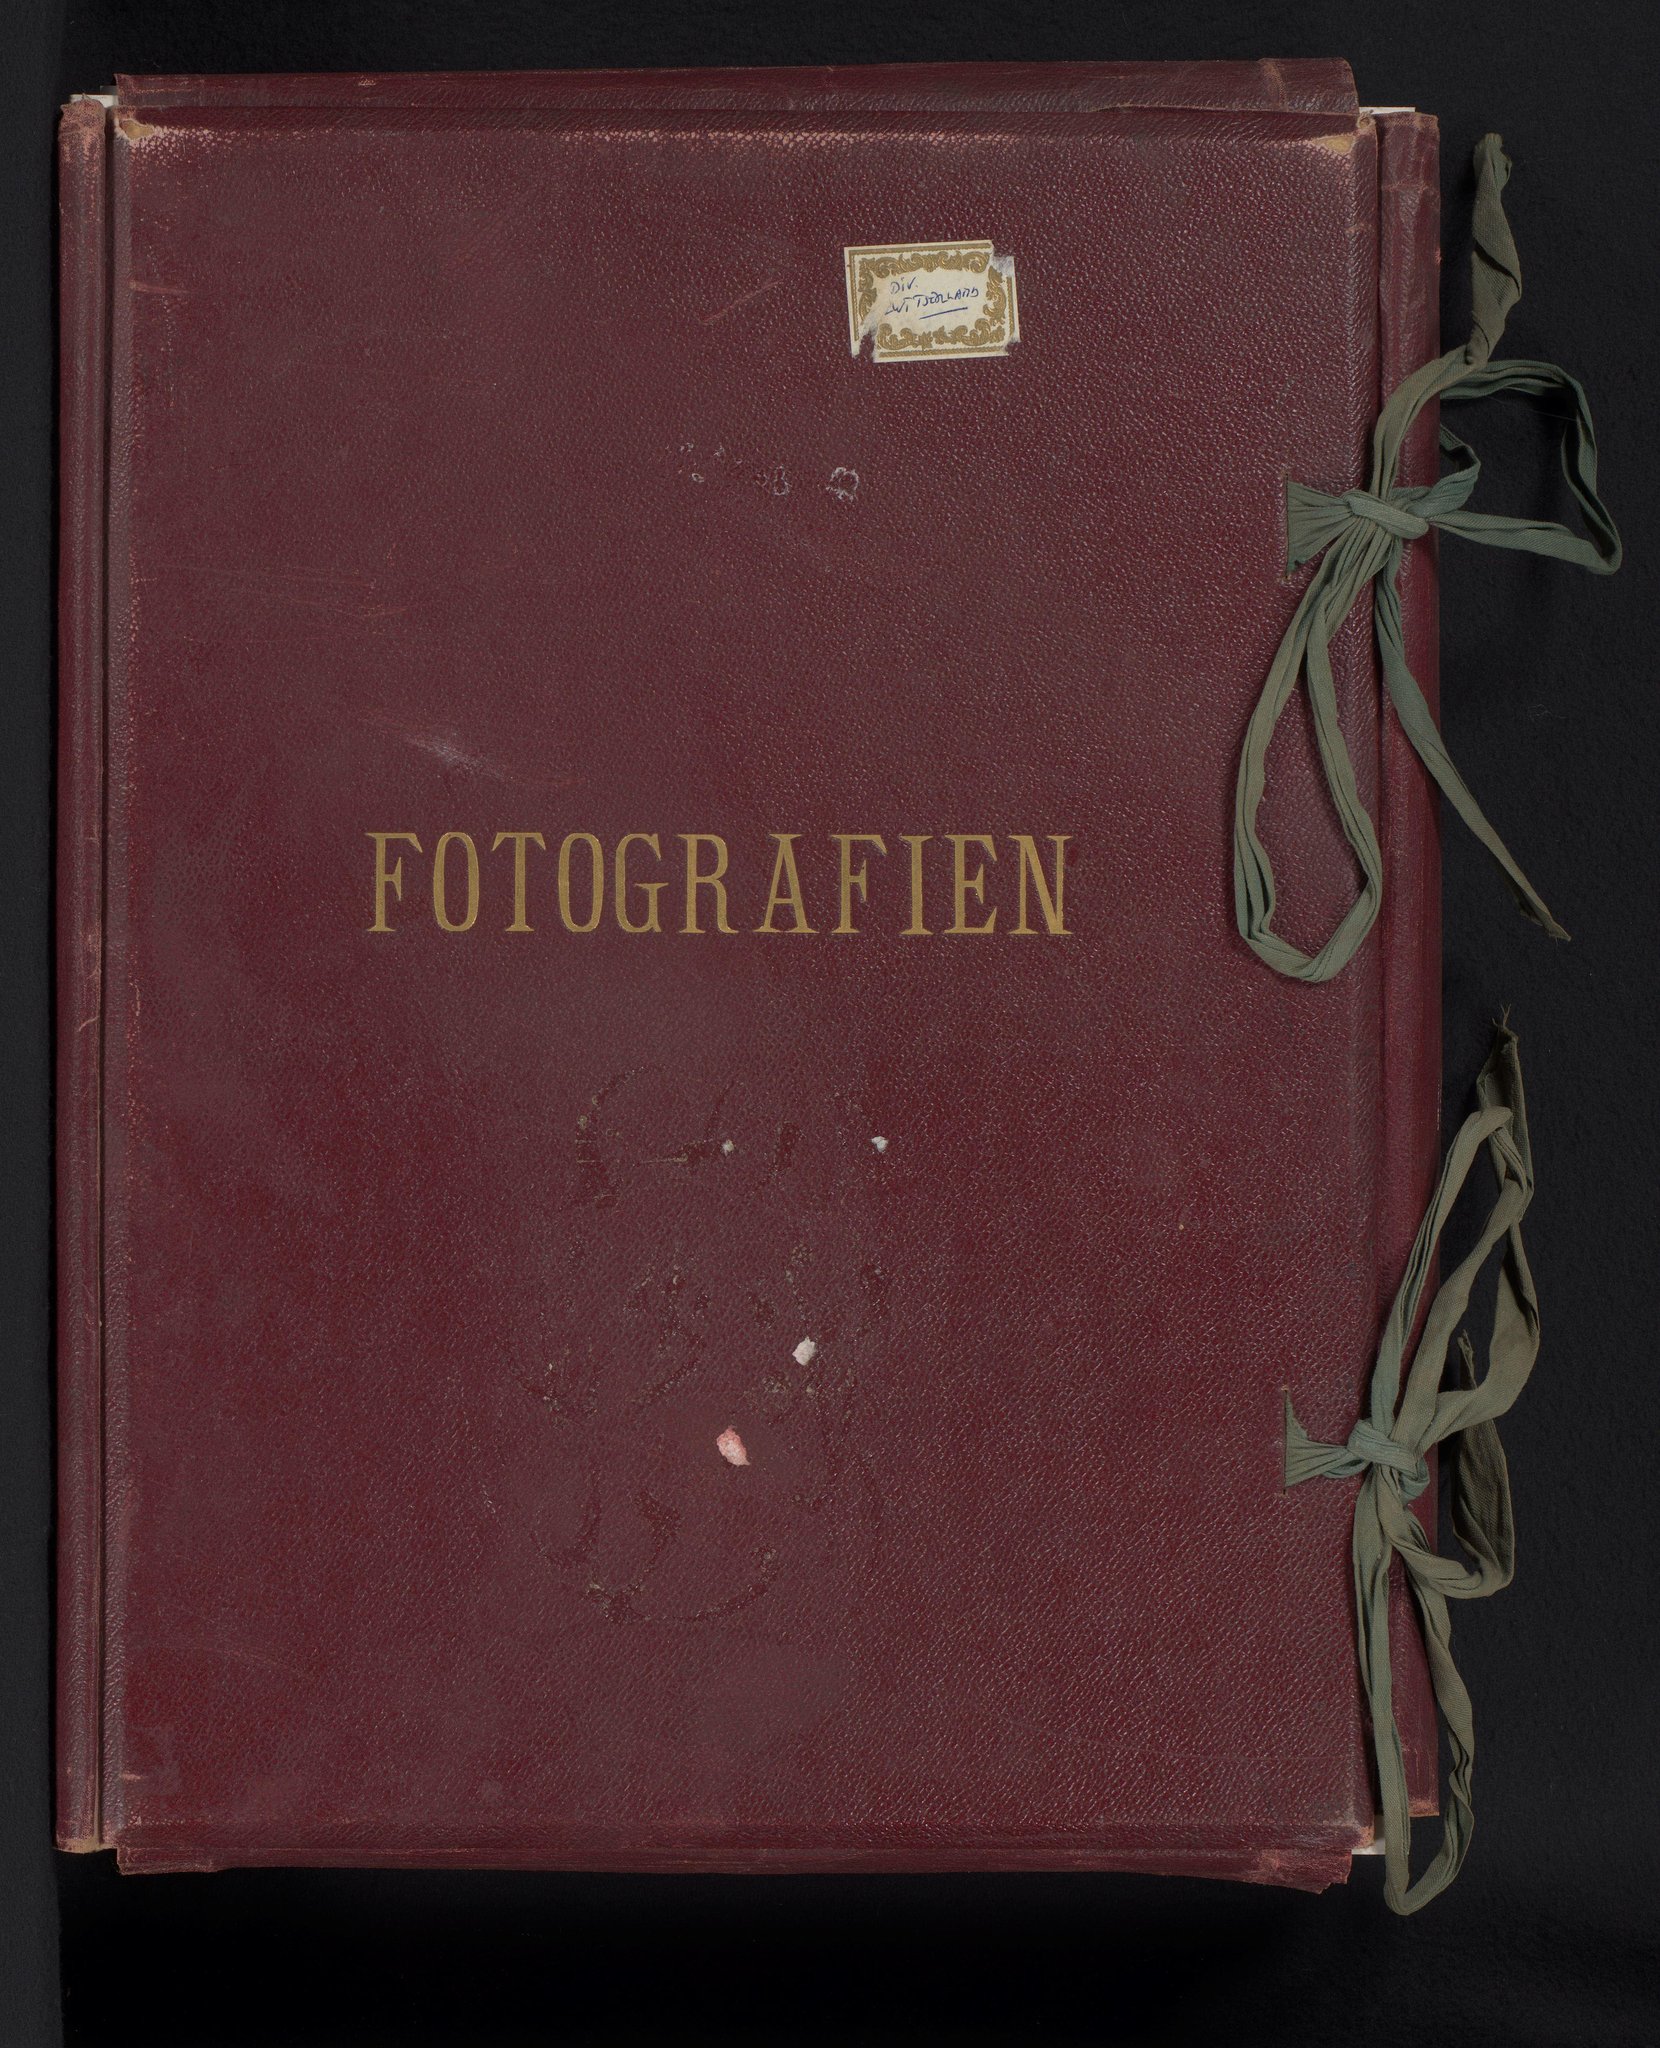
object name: photograph album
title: Fotografien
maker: Anonymous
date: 1885-1920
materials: paper, cardboard, leather, textile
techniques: photograph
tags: city-view in general; 'veduta', lake, railway, train, mountains, germany, switzerland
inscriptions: inscription: ‘Fotografien’, inscription: ‘Div./ Zwitserland’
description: Omslag met dertien foto's en 35 lichtdrukken op 42 kartonnen bladen. Van de foto's zijn er zes daglichtgelatinezilverdrukken en zeven daglichtcollodiumzilverdrukken. Van vier lichtdrukken is de fotograaf J. Jullien, van de andere foto's en lichtdrukken is de maker onbekend. Twaalf lichtdrukken zijn uitgegeven door Photoglob en zeven door de Gebrüder Wehrli.